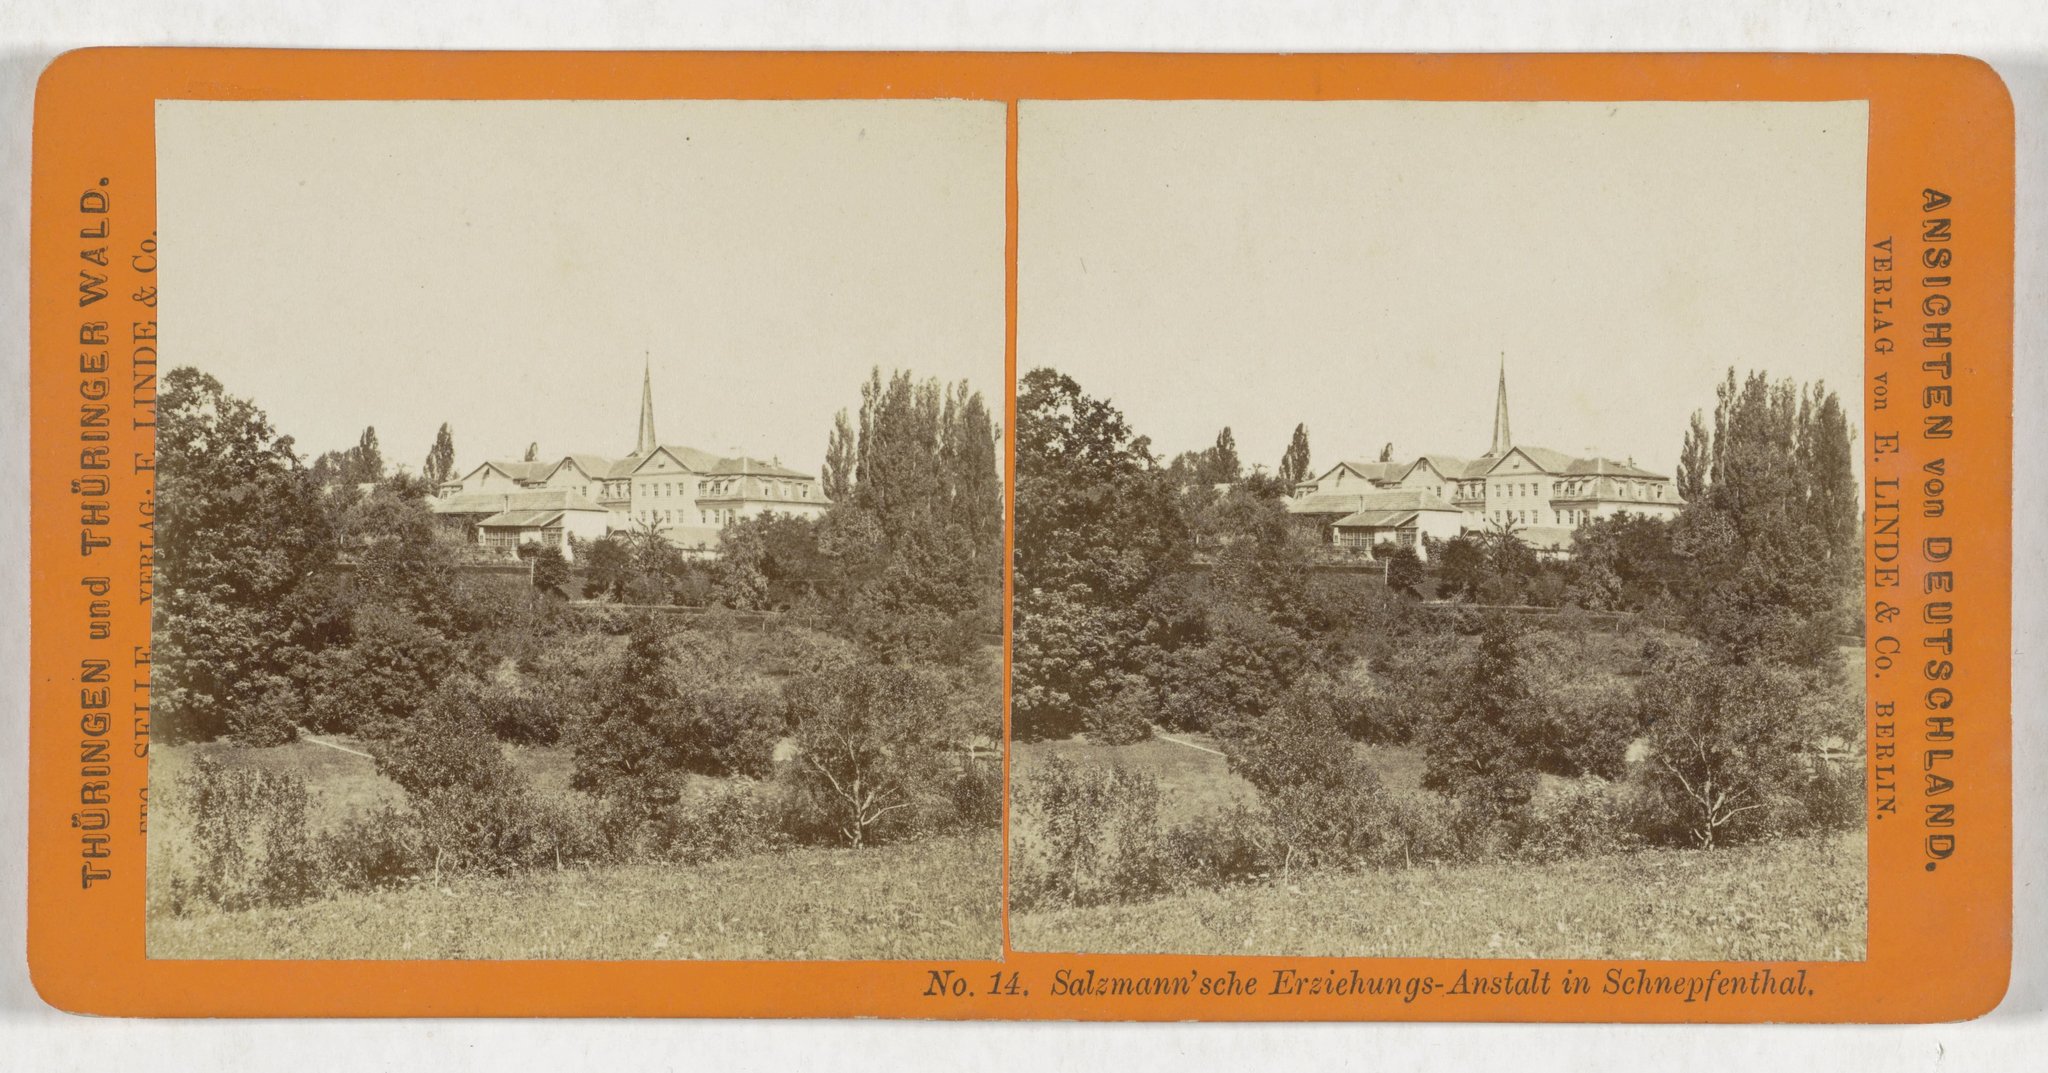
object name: stereograph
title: Ansichten von Deutschland / Thüringen und Thüringer Wald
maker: hermann selle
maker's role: fotograaf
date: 1868-1890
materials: cardboard, paper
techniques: albumen print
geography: berlin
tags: secondary education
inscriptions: number: ‘No. 14.’